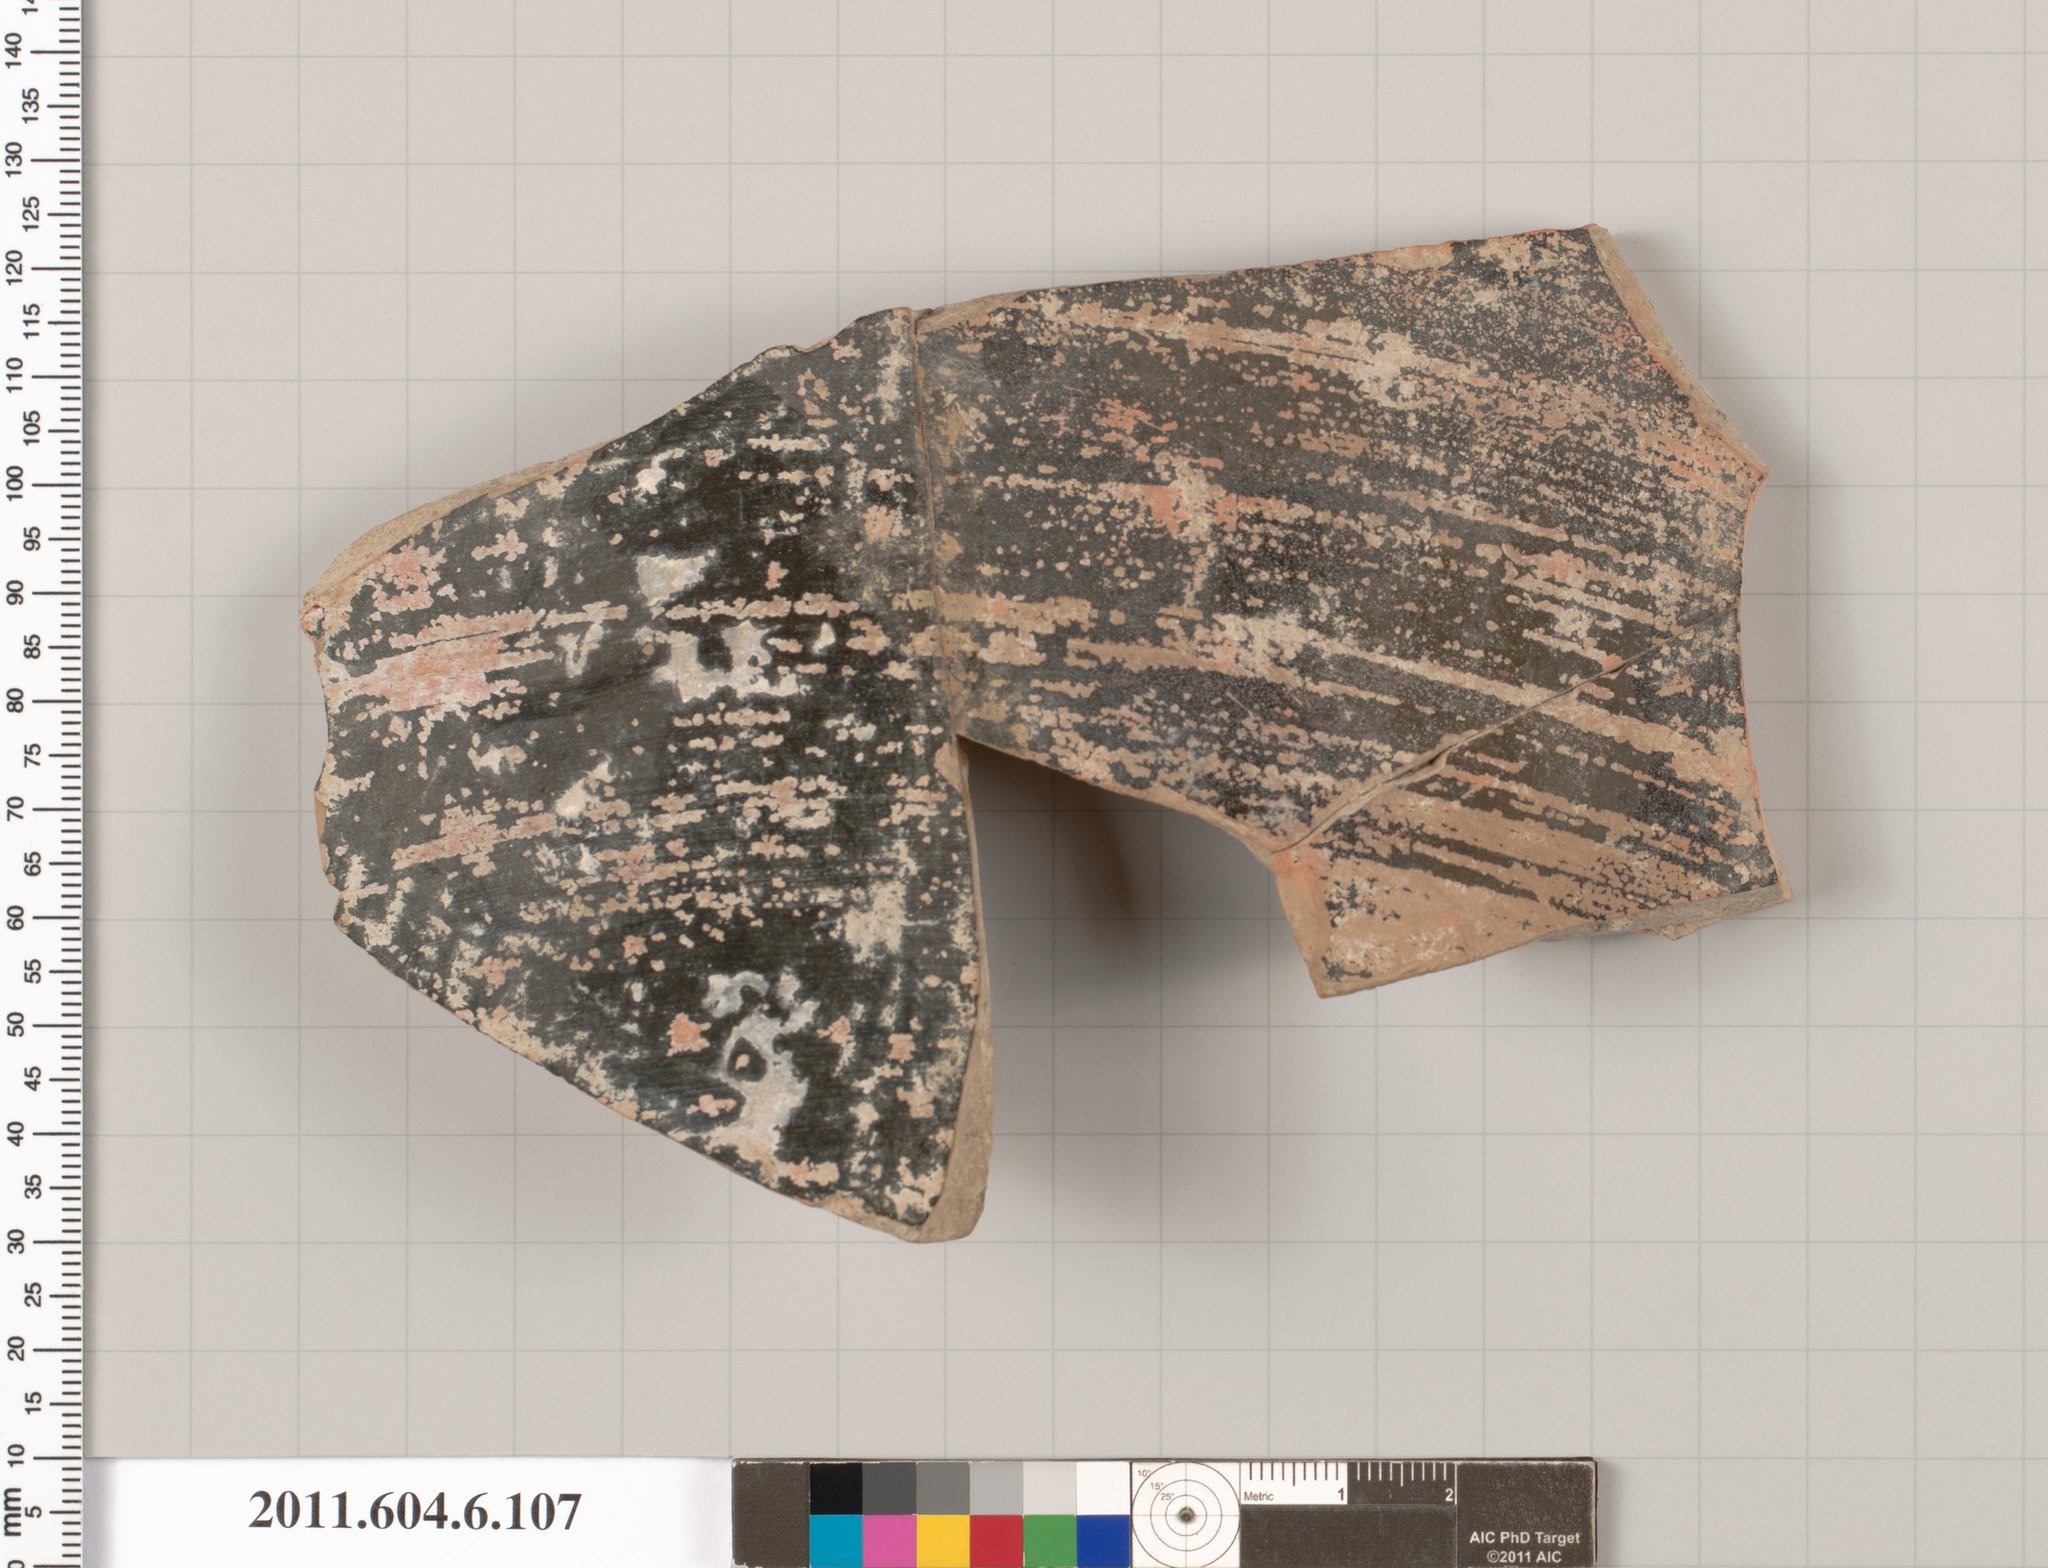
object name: amphora fragment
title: Terracotta fragment of an amphora (jar)?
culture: greek, attic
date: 600-501 BCE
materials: terracotta